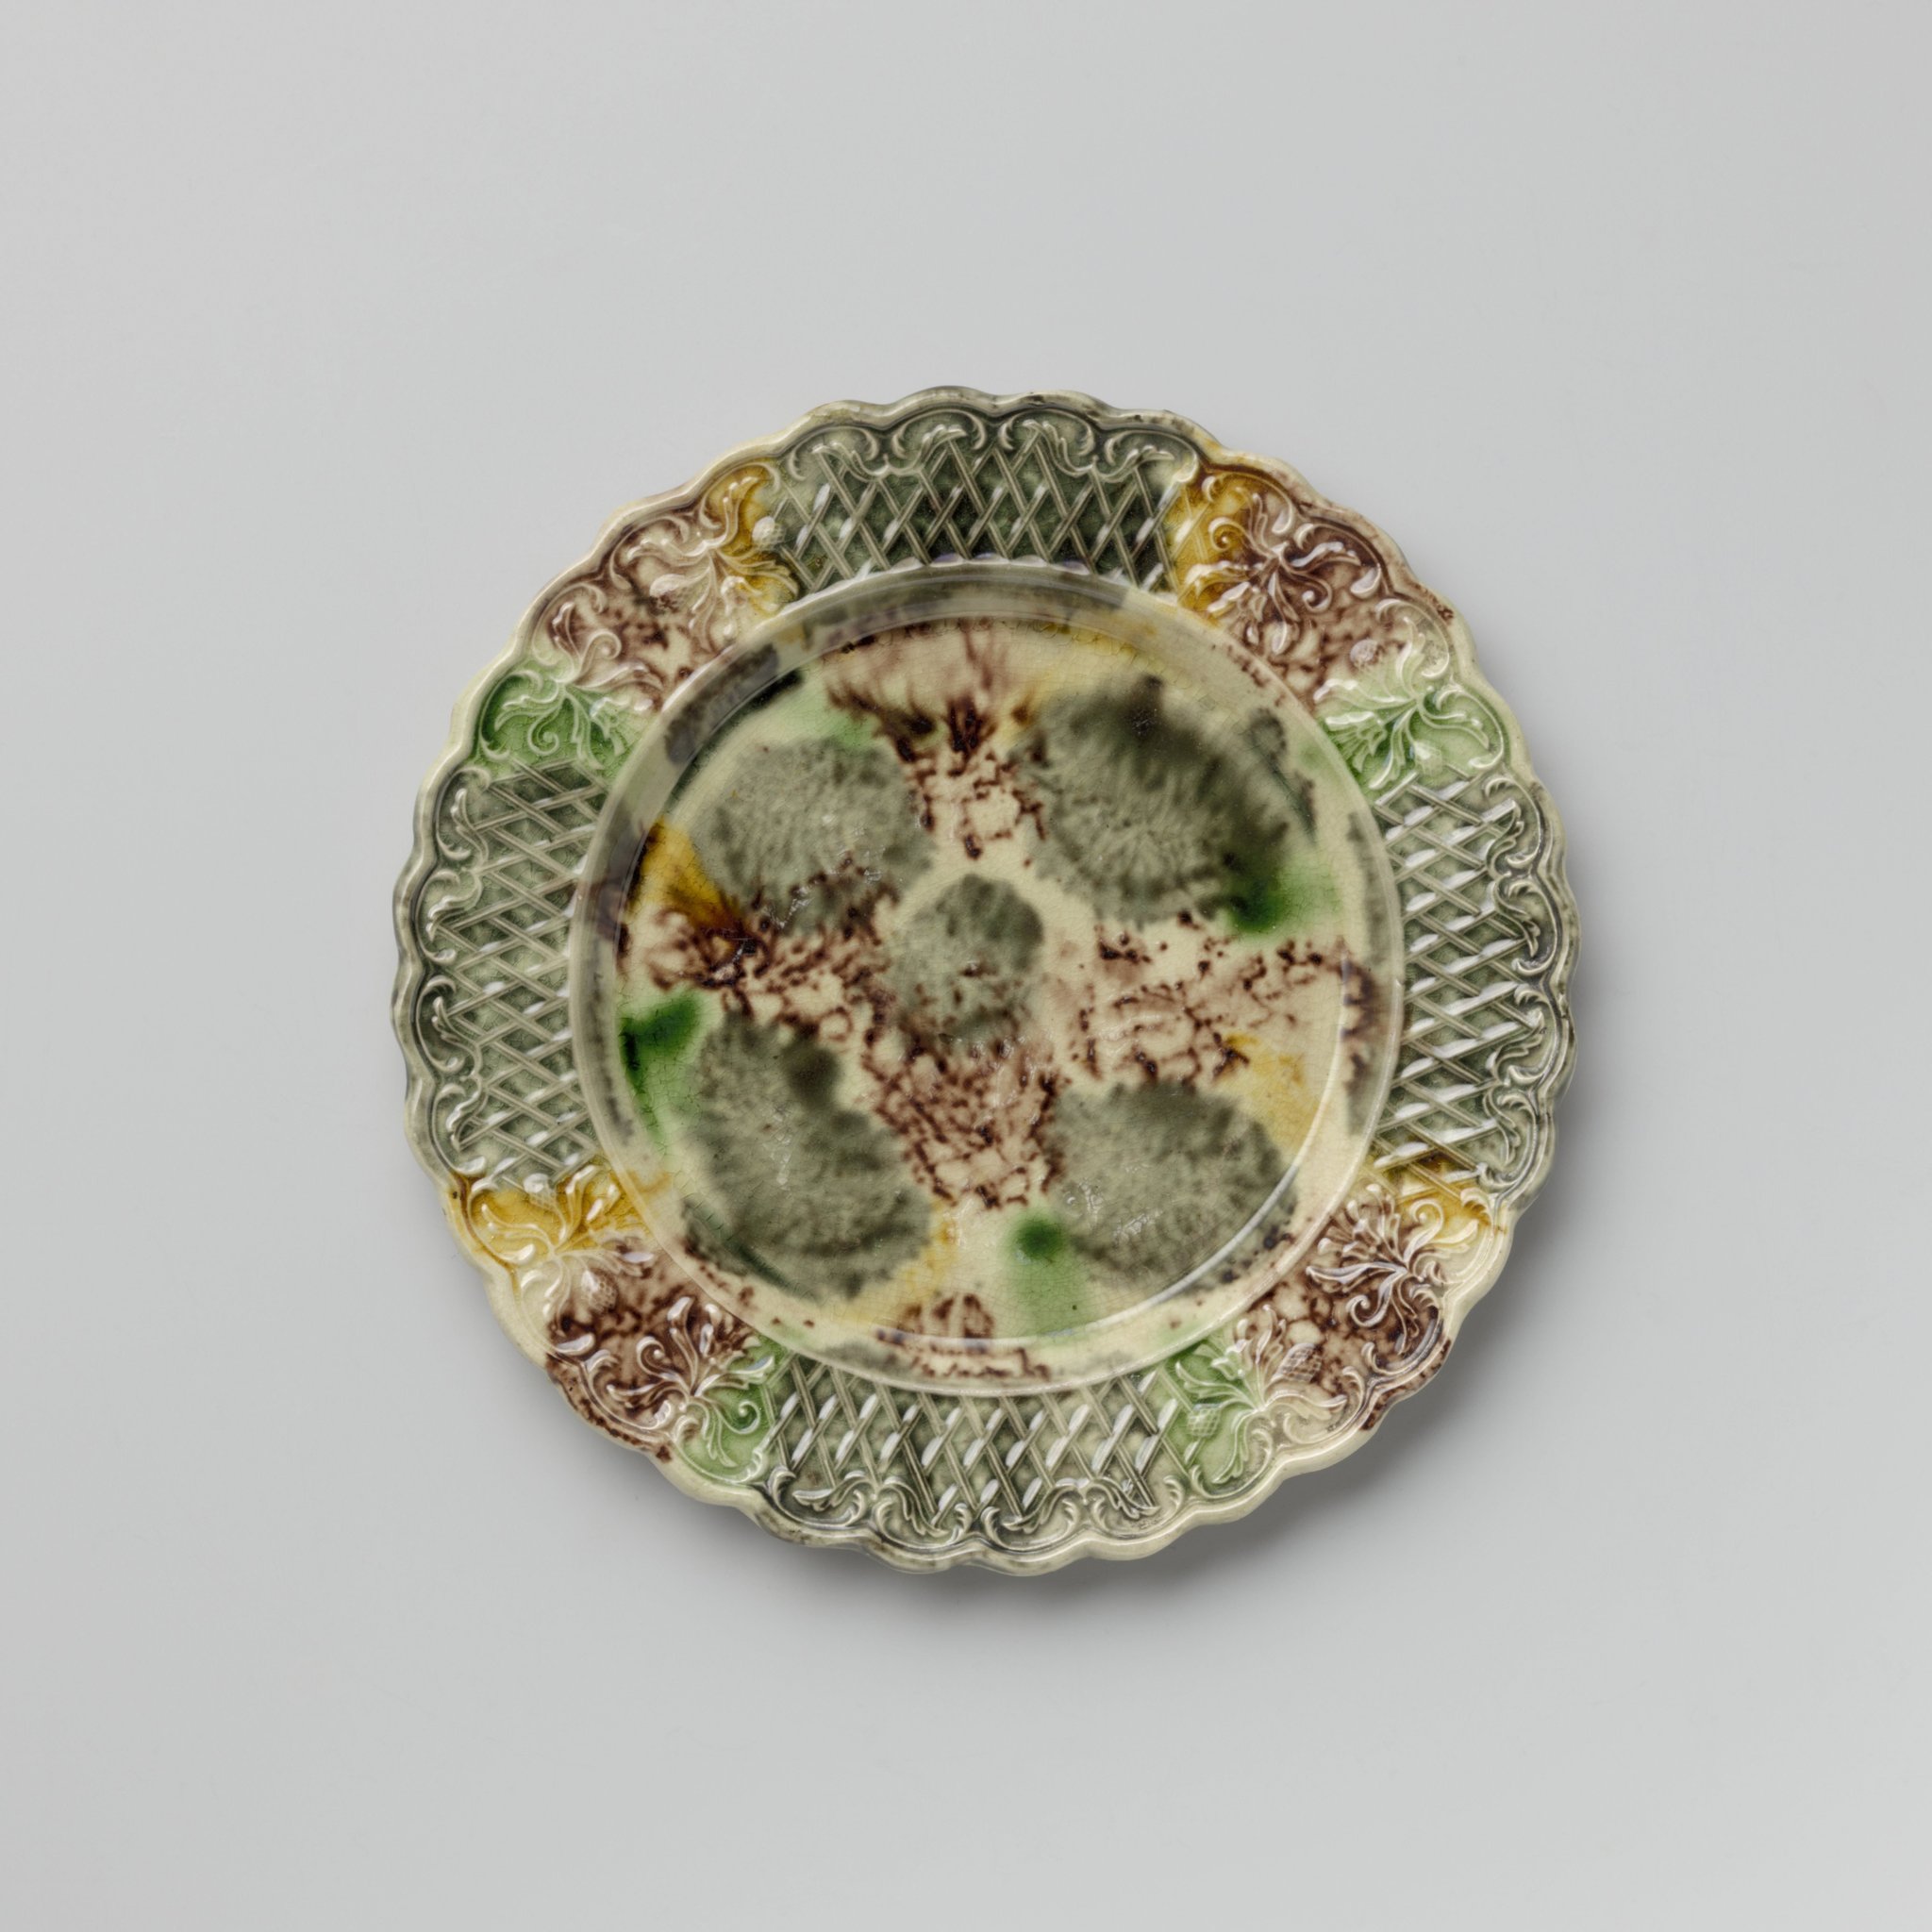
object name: plate dish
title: Bord van veelkleurig hardgebakken aardewerk; Staffordshire.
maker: Anonymous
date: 1750-1780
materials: earthenware, glaze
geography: england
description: Bord van veelkleurig hardgebakken aardewerk. De rand is in reliëf versierd met traliewerk, afgewisseld met twee naast elkaar geplaatste symmetrische bloemmotieven. De geschulpte rand is aan de binnenkant versierd met voluten en bladmotieven. Het bord is bedekt met een gevlekte loodglazuur in mangaan, groen, grijs en geel. De achterkant is in mangaan gestippeld en heeft een voetrand. Het bord hoort bij vijf borden (BK-1987-39-A t/m BK-1987-39-F).